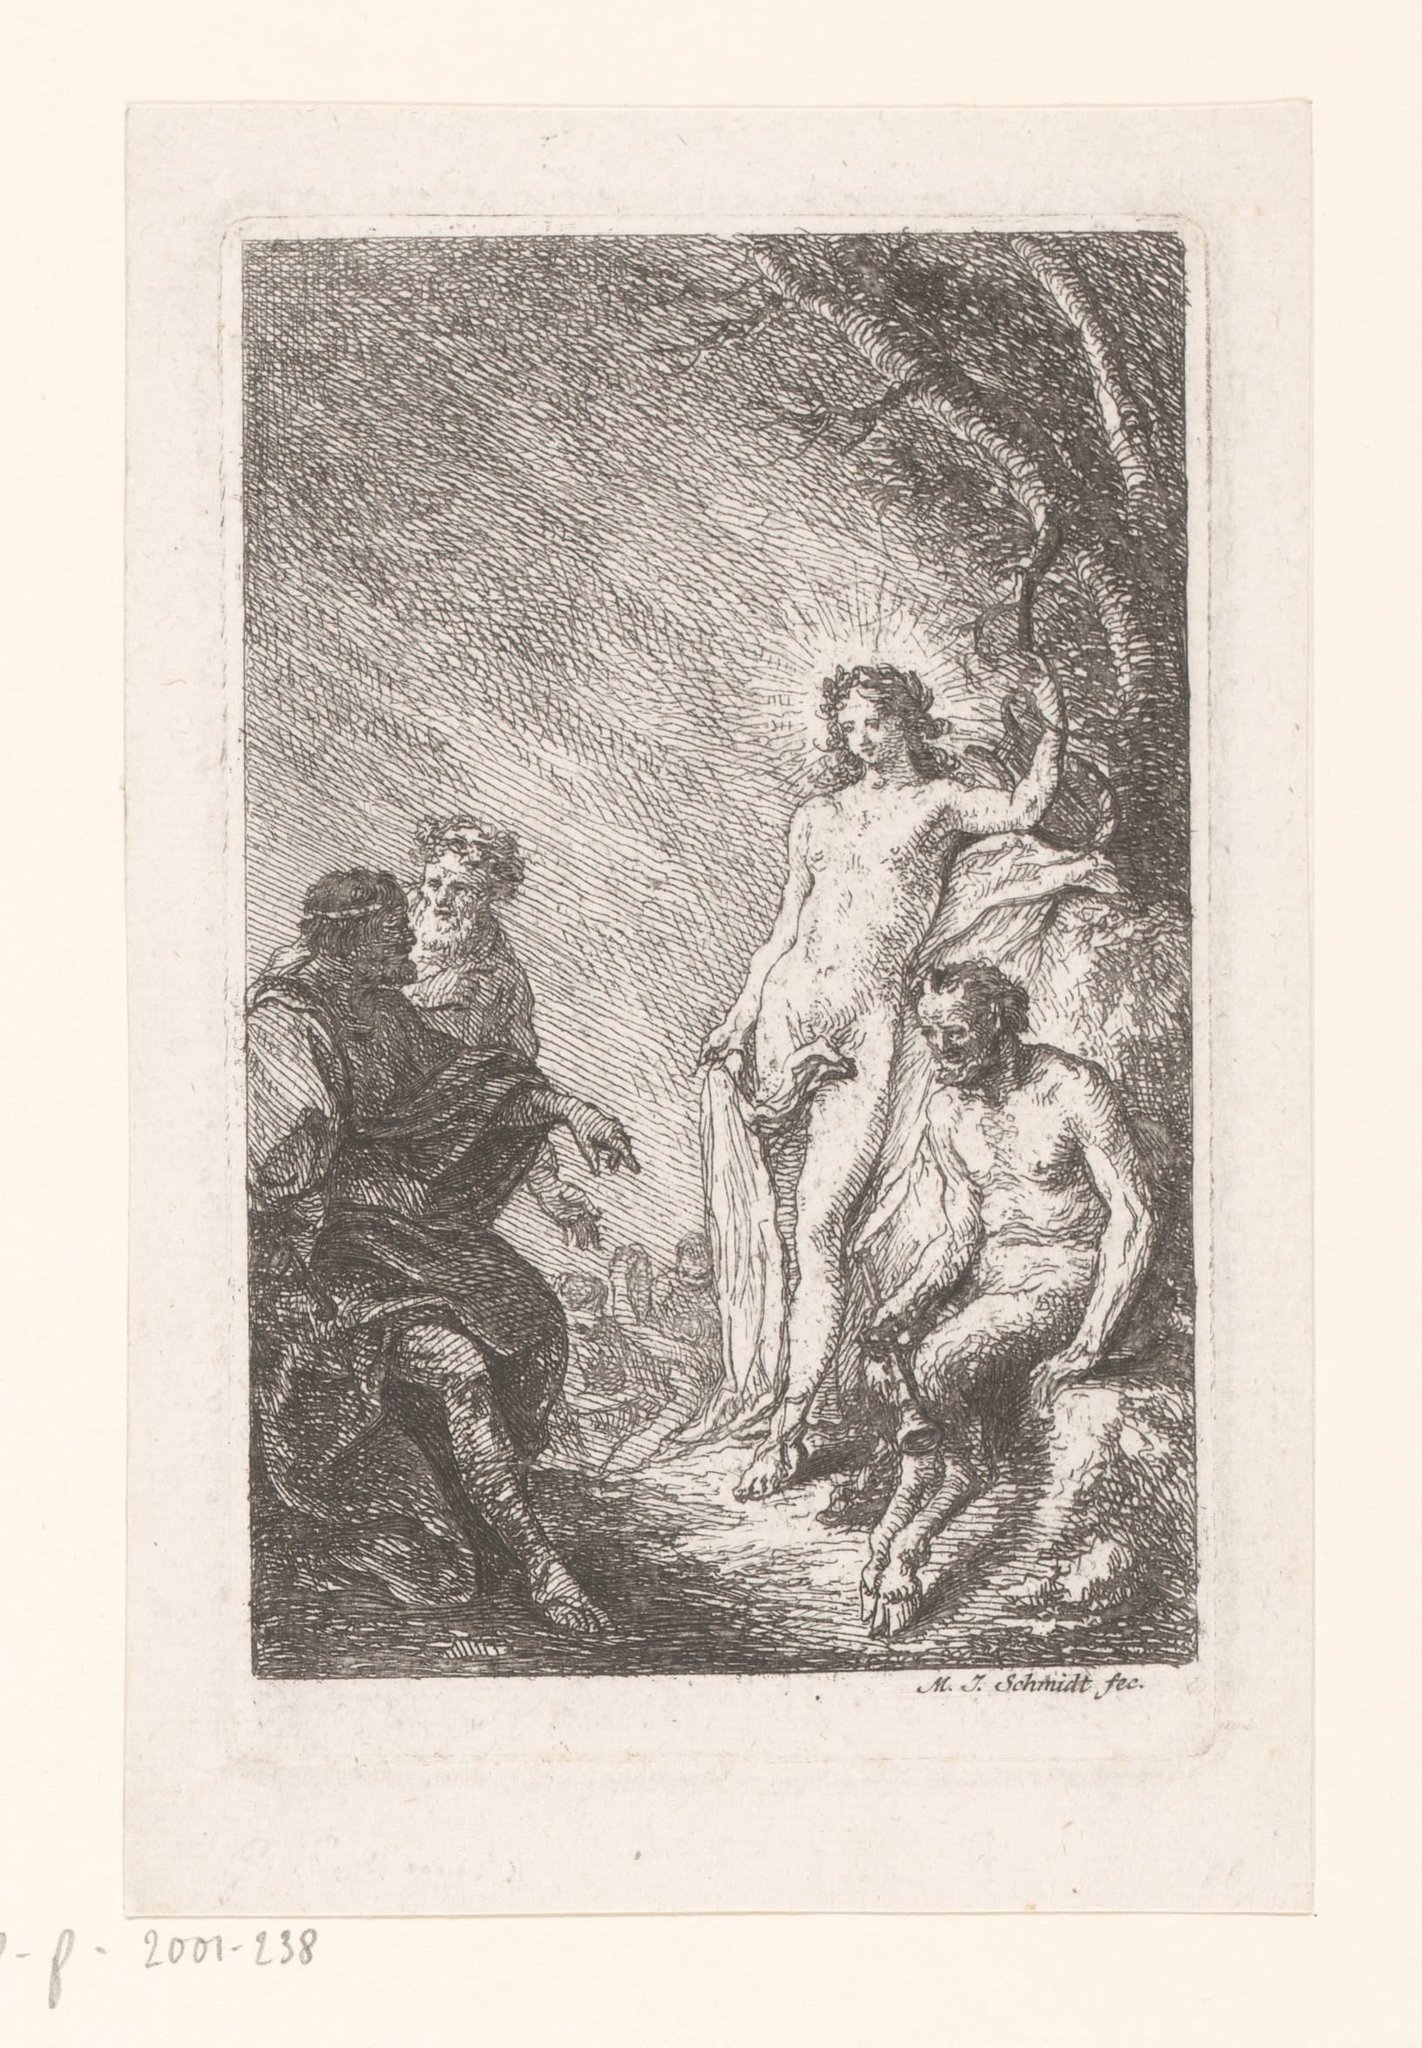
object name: print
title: Oordeel van Midas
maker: martin johann schmidt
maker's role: draughtsman, print maker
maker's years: 1718-1801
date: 1771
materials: paper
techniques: etching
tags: midas given ass's ears: apollo gives midas ass's ears as punishment for preferring pan in the musical contest between apollo and pan (ovid, metamorphoses xi 174)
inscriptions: collector's mark: Lugt 2228, collector's mark: Lugt 2760